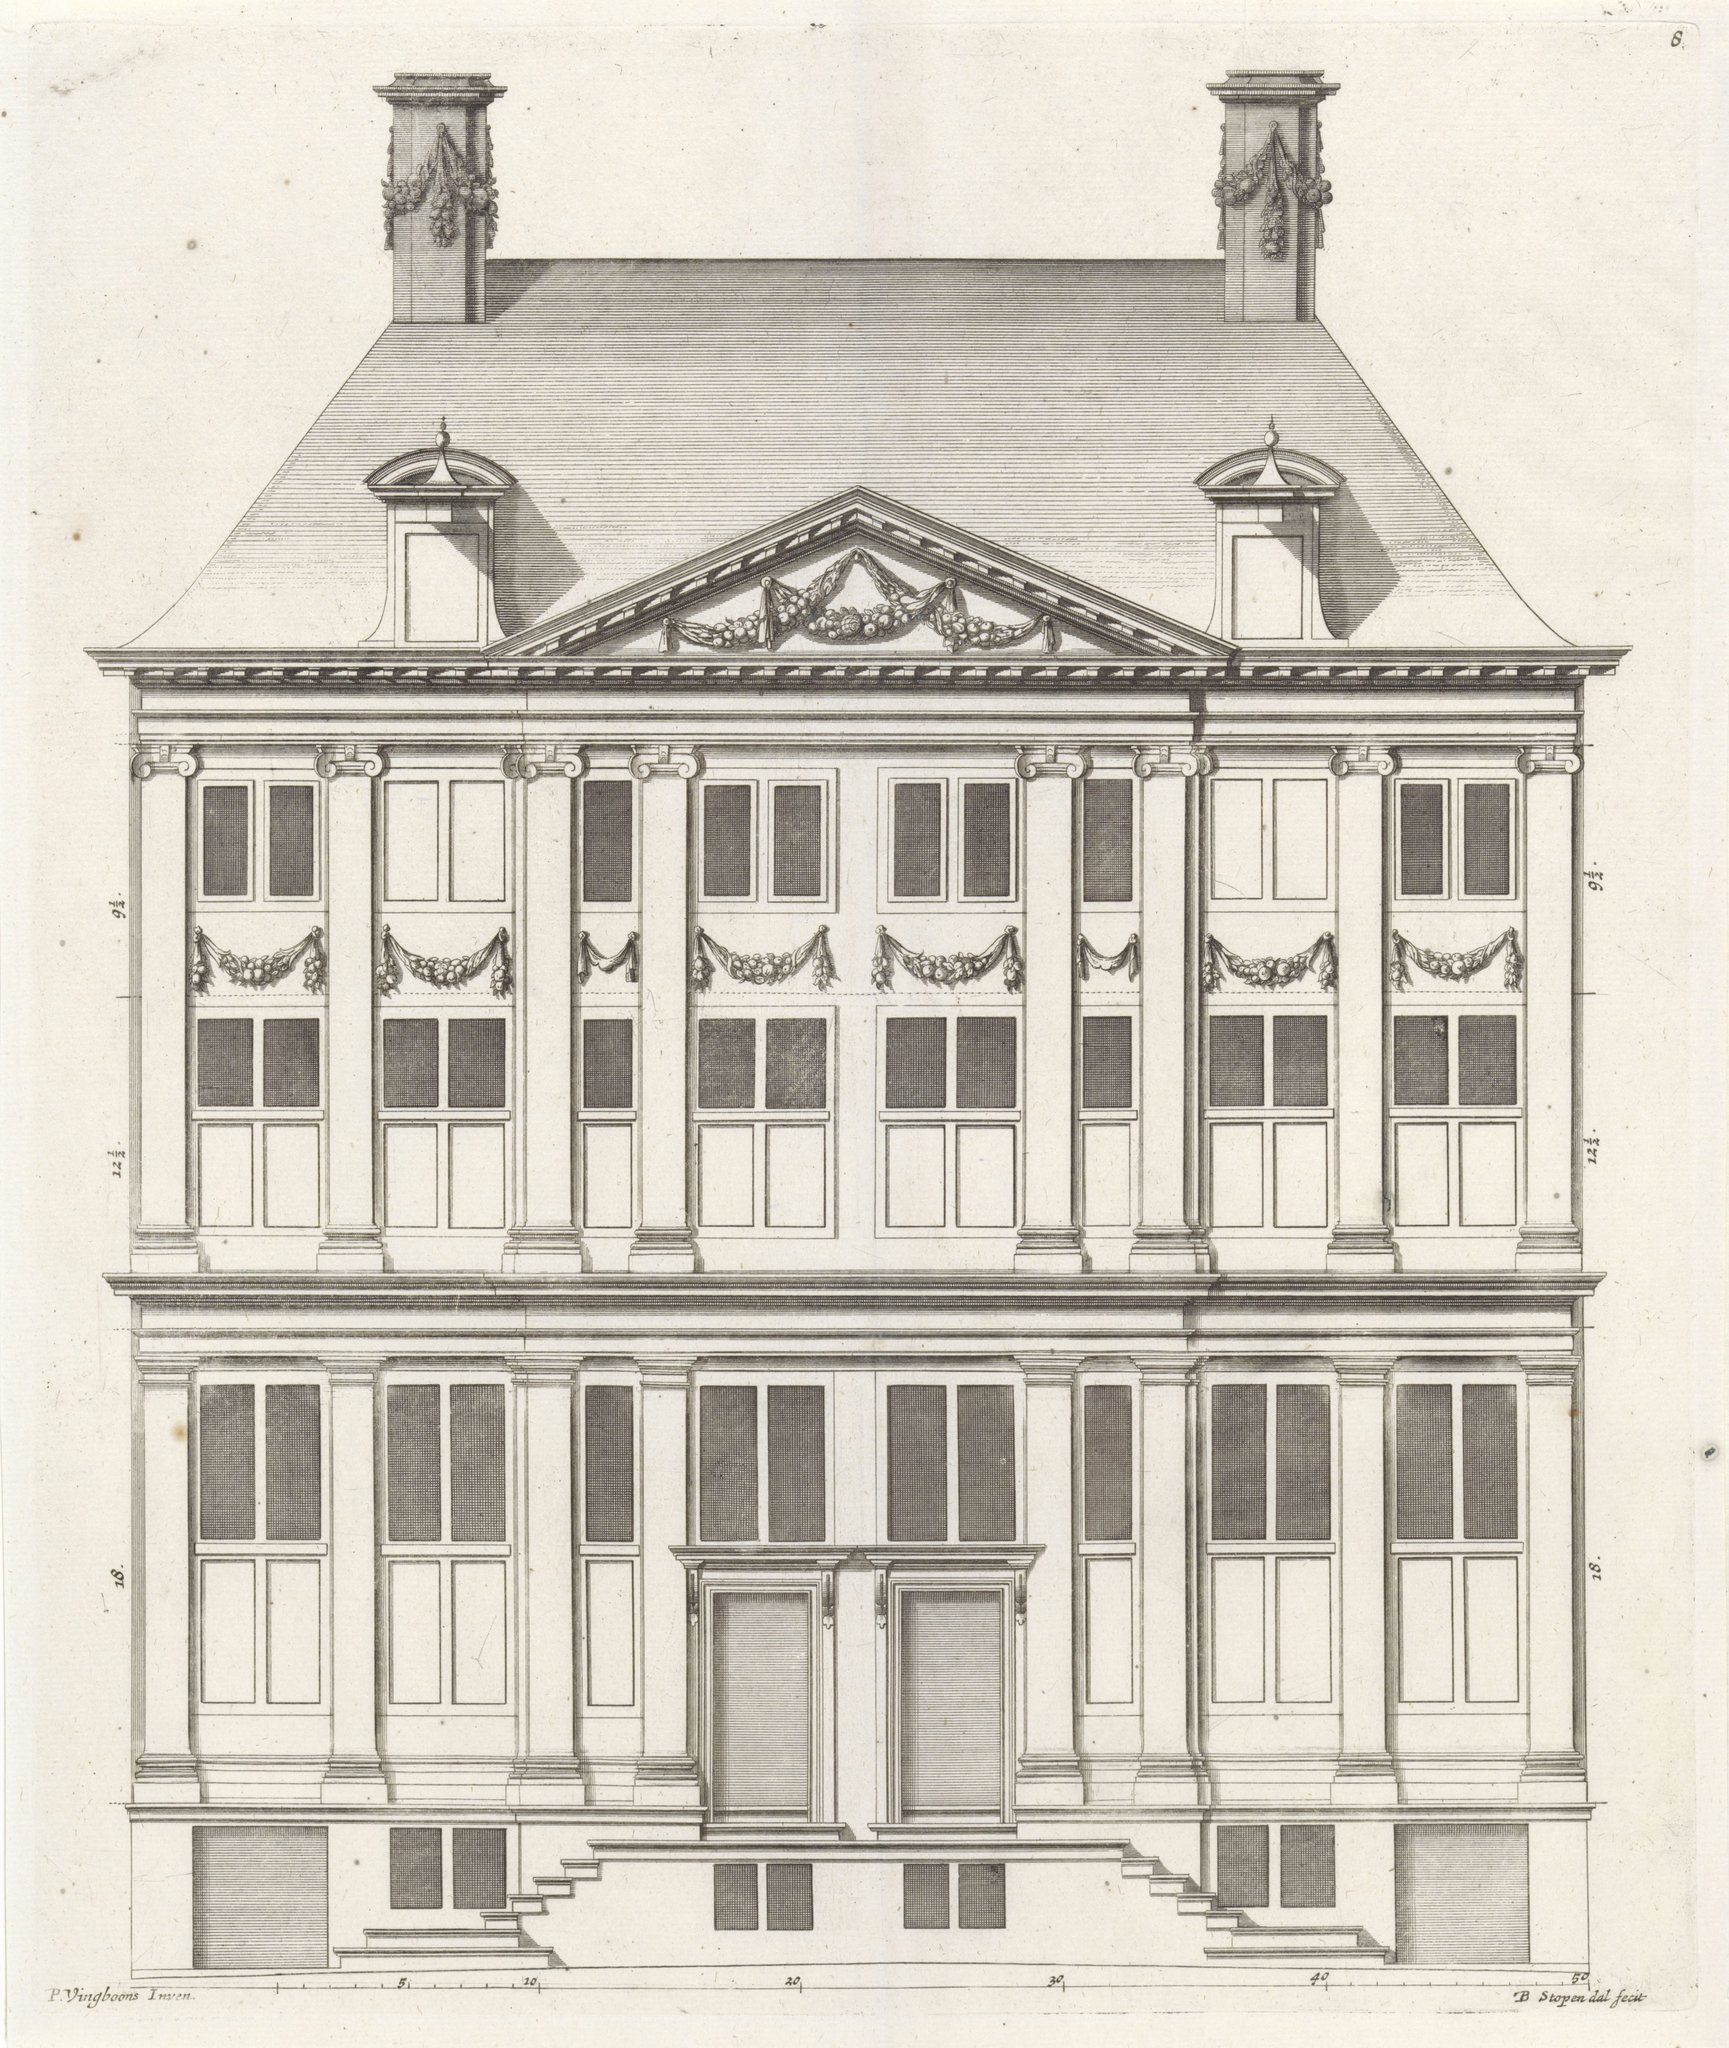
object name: print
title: Gevel van een dubbelwoonhuis aan de Oudezijds Voorburgwal te Amsterdam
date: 1674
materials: paper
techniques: engraving, etching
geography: amsterdam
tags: exterior ~ architectural design or model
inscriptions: collector's mark: Lugt 2228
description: Prent uit: Vingboons, Philips. Tweede deel van de afbeeldsels der voornaemste gebovwen, uyt alle die Philips Vingboons geordineert heeft. Amsterdam: Philips Vingboons en Joan Blaeu, 1674. Prent ook gebruikt in: Vingboons, Philips. De gronden afbeeldingen en beschryvingen der aldervoornaamste en aldernieuwste gebouwen uyt alle die door Philippus Vingboons, binnen Amsterdam (...) en elders geordonneerd zyn. Leiden: Pieter van der Aa(I), 1715.